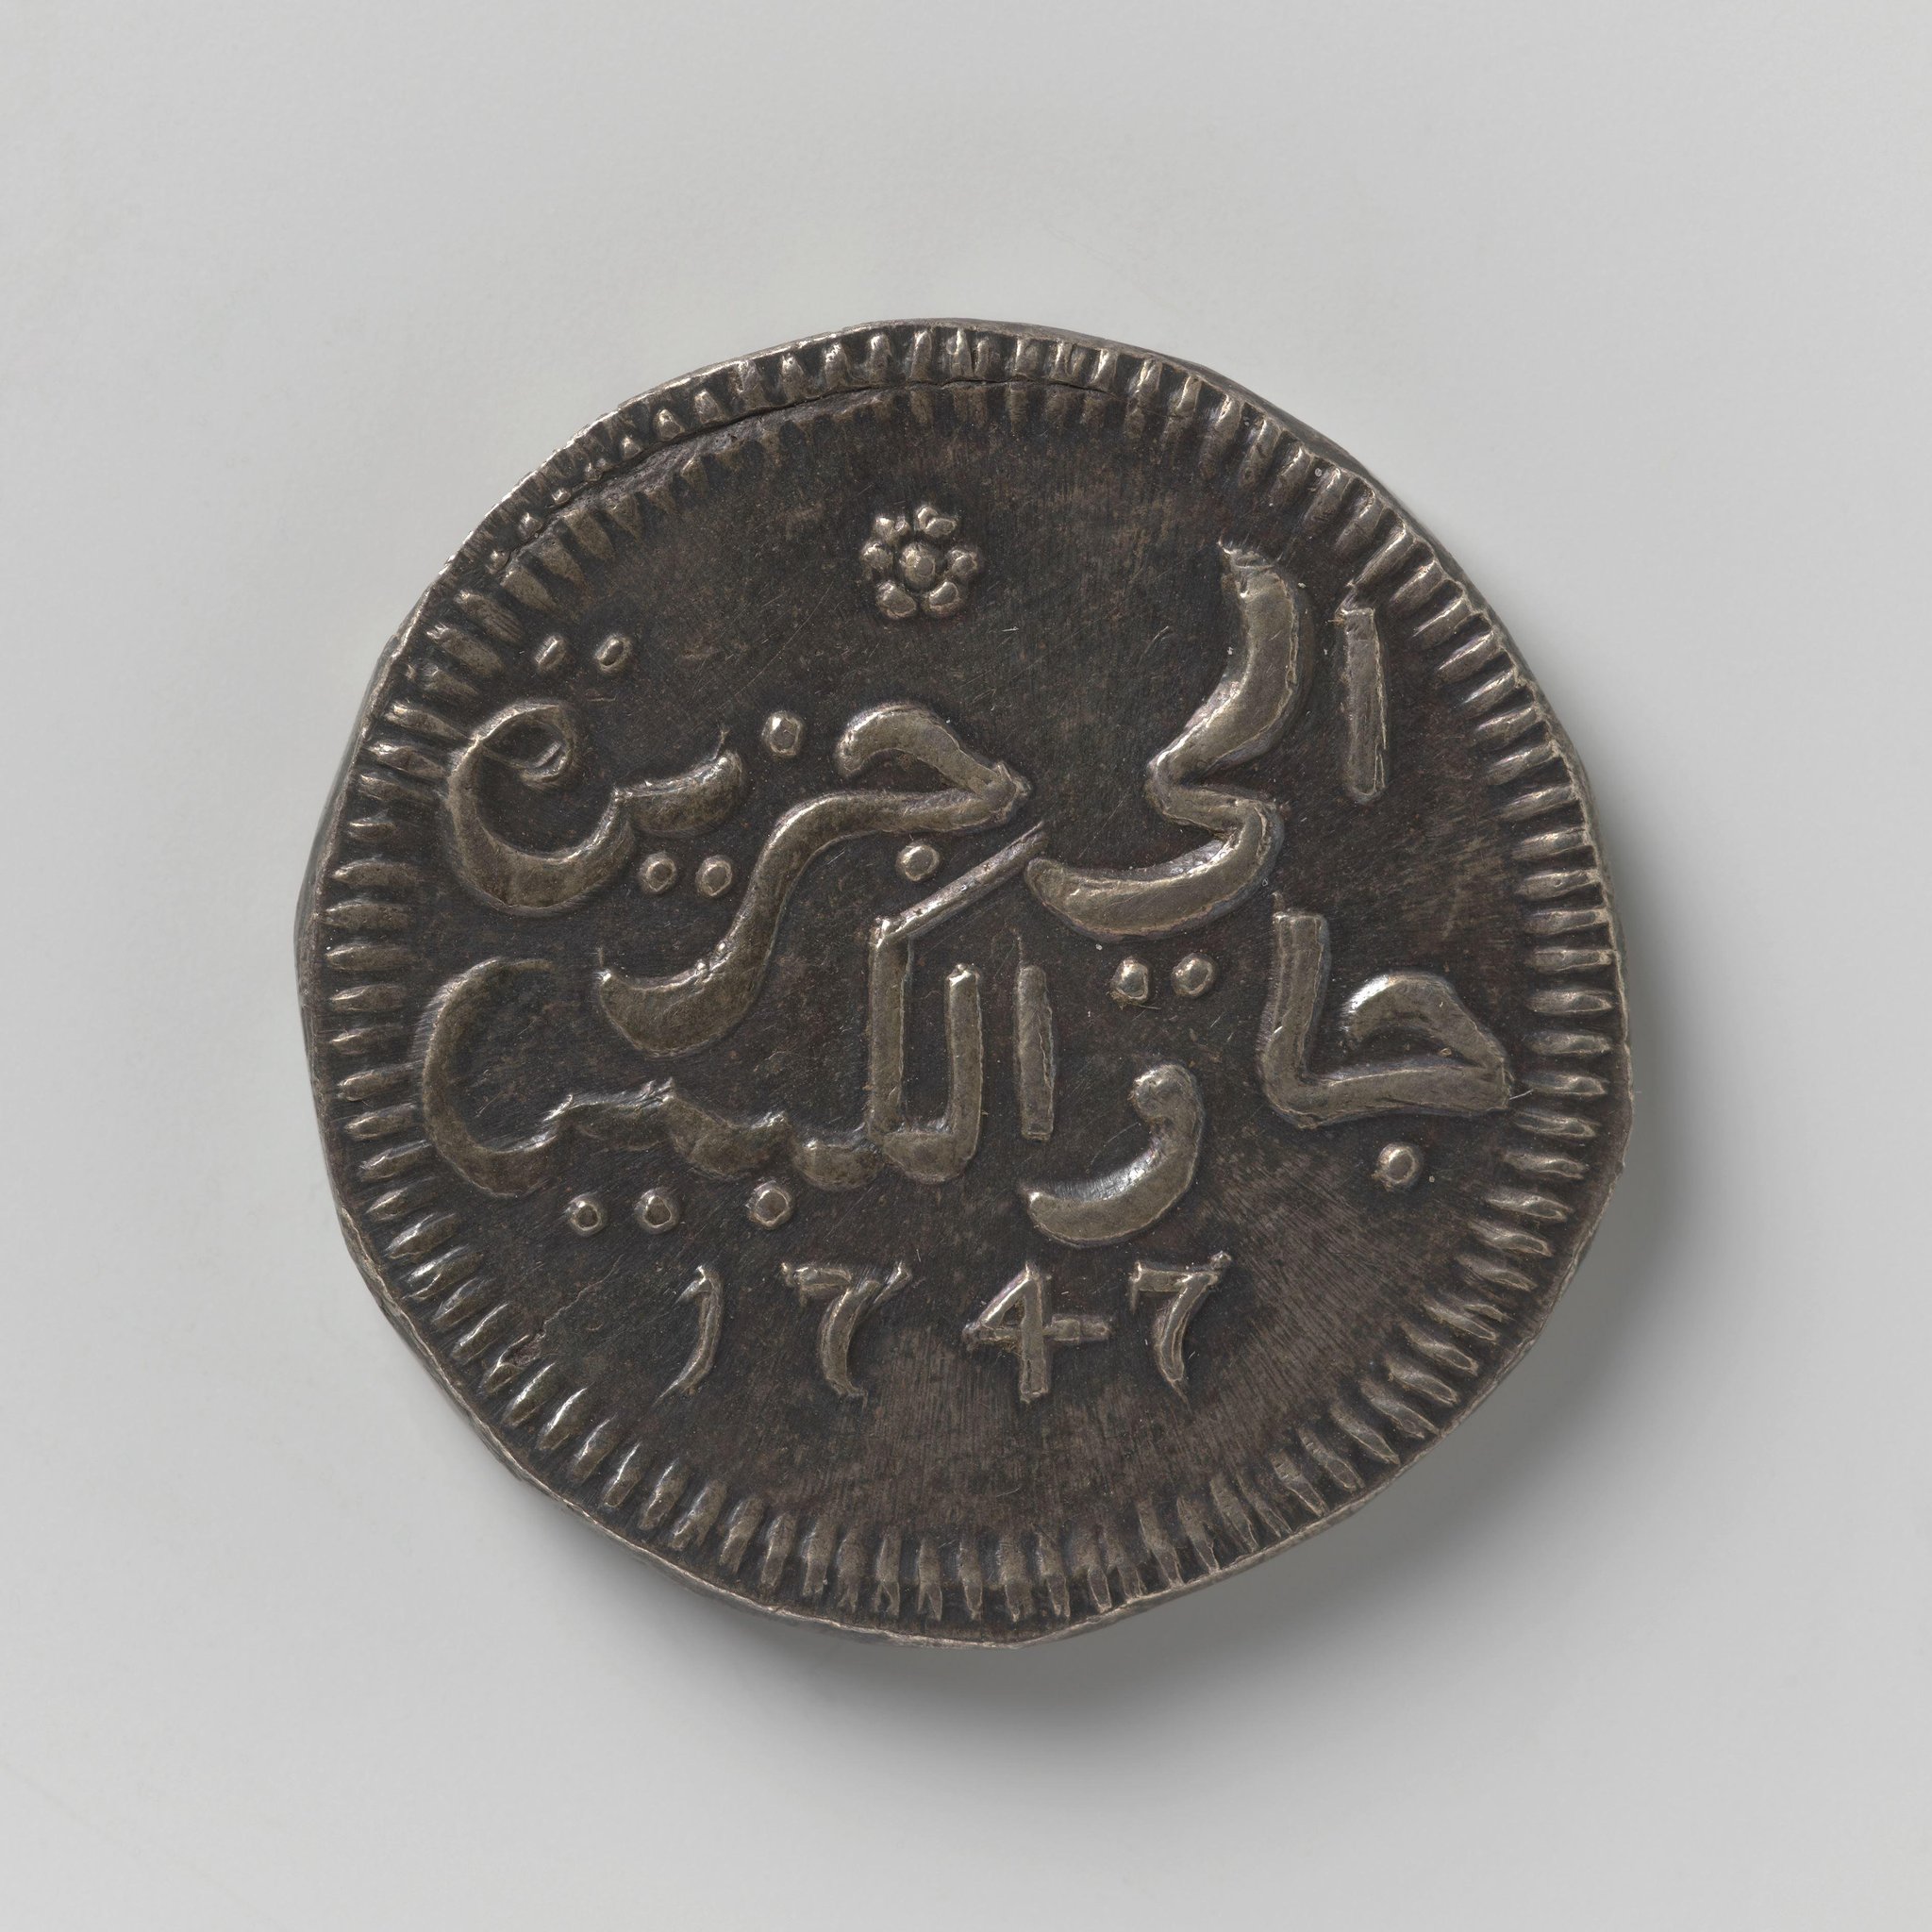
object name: coin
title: Zilveren ropij van de VOC uit Java, 1747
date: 1747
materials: silver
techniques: striking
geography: batavia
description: Zilveren munt. Voorzijde: tweeregelig opschrift in Arabische letters. Daarboven muntteken en daaronder jaartal. Keerzijde: drieregelig opschrift in Arabische letters. Gladde rand.